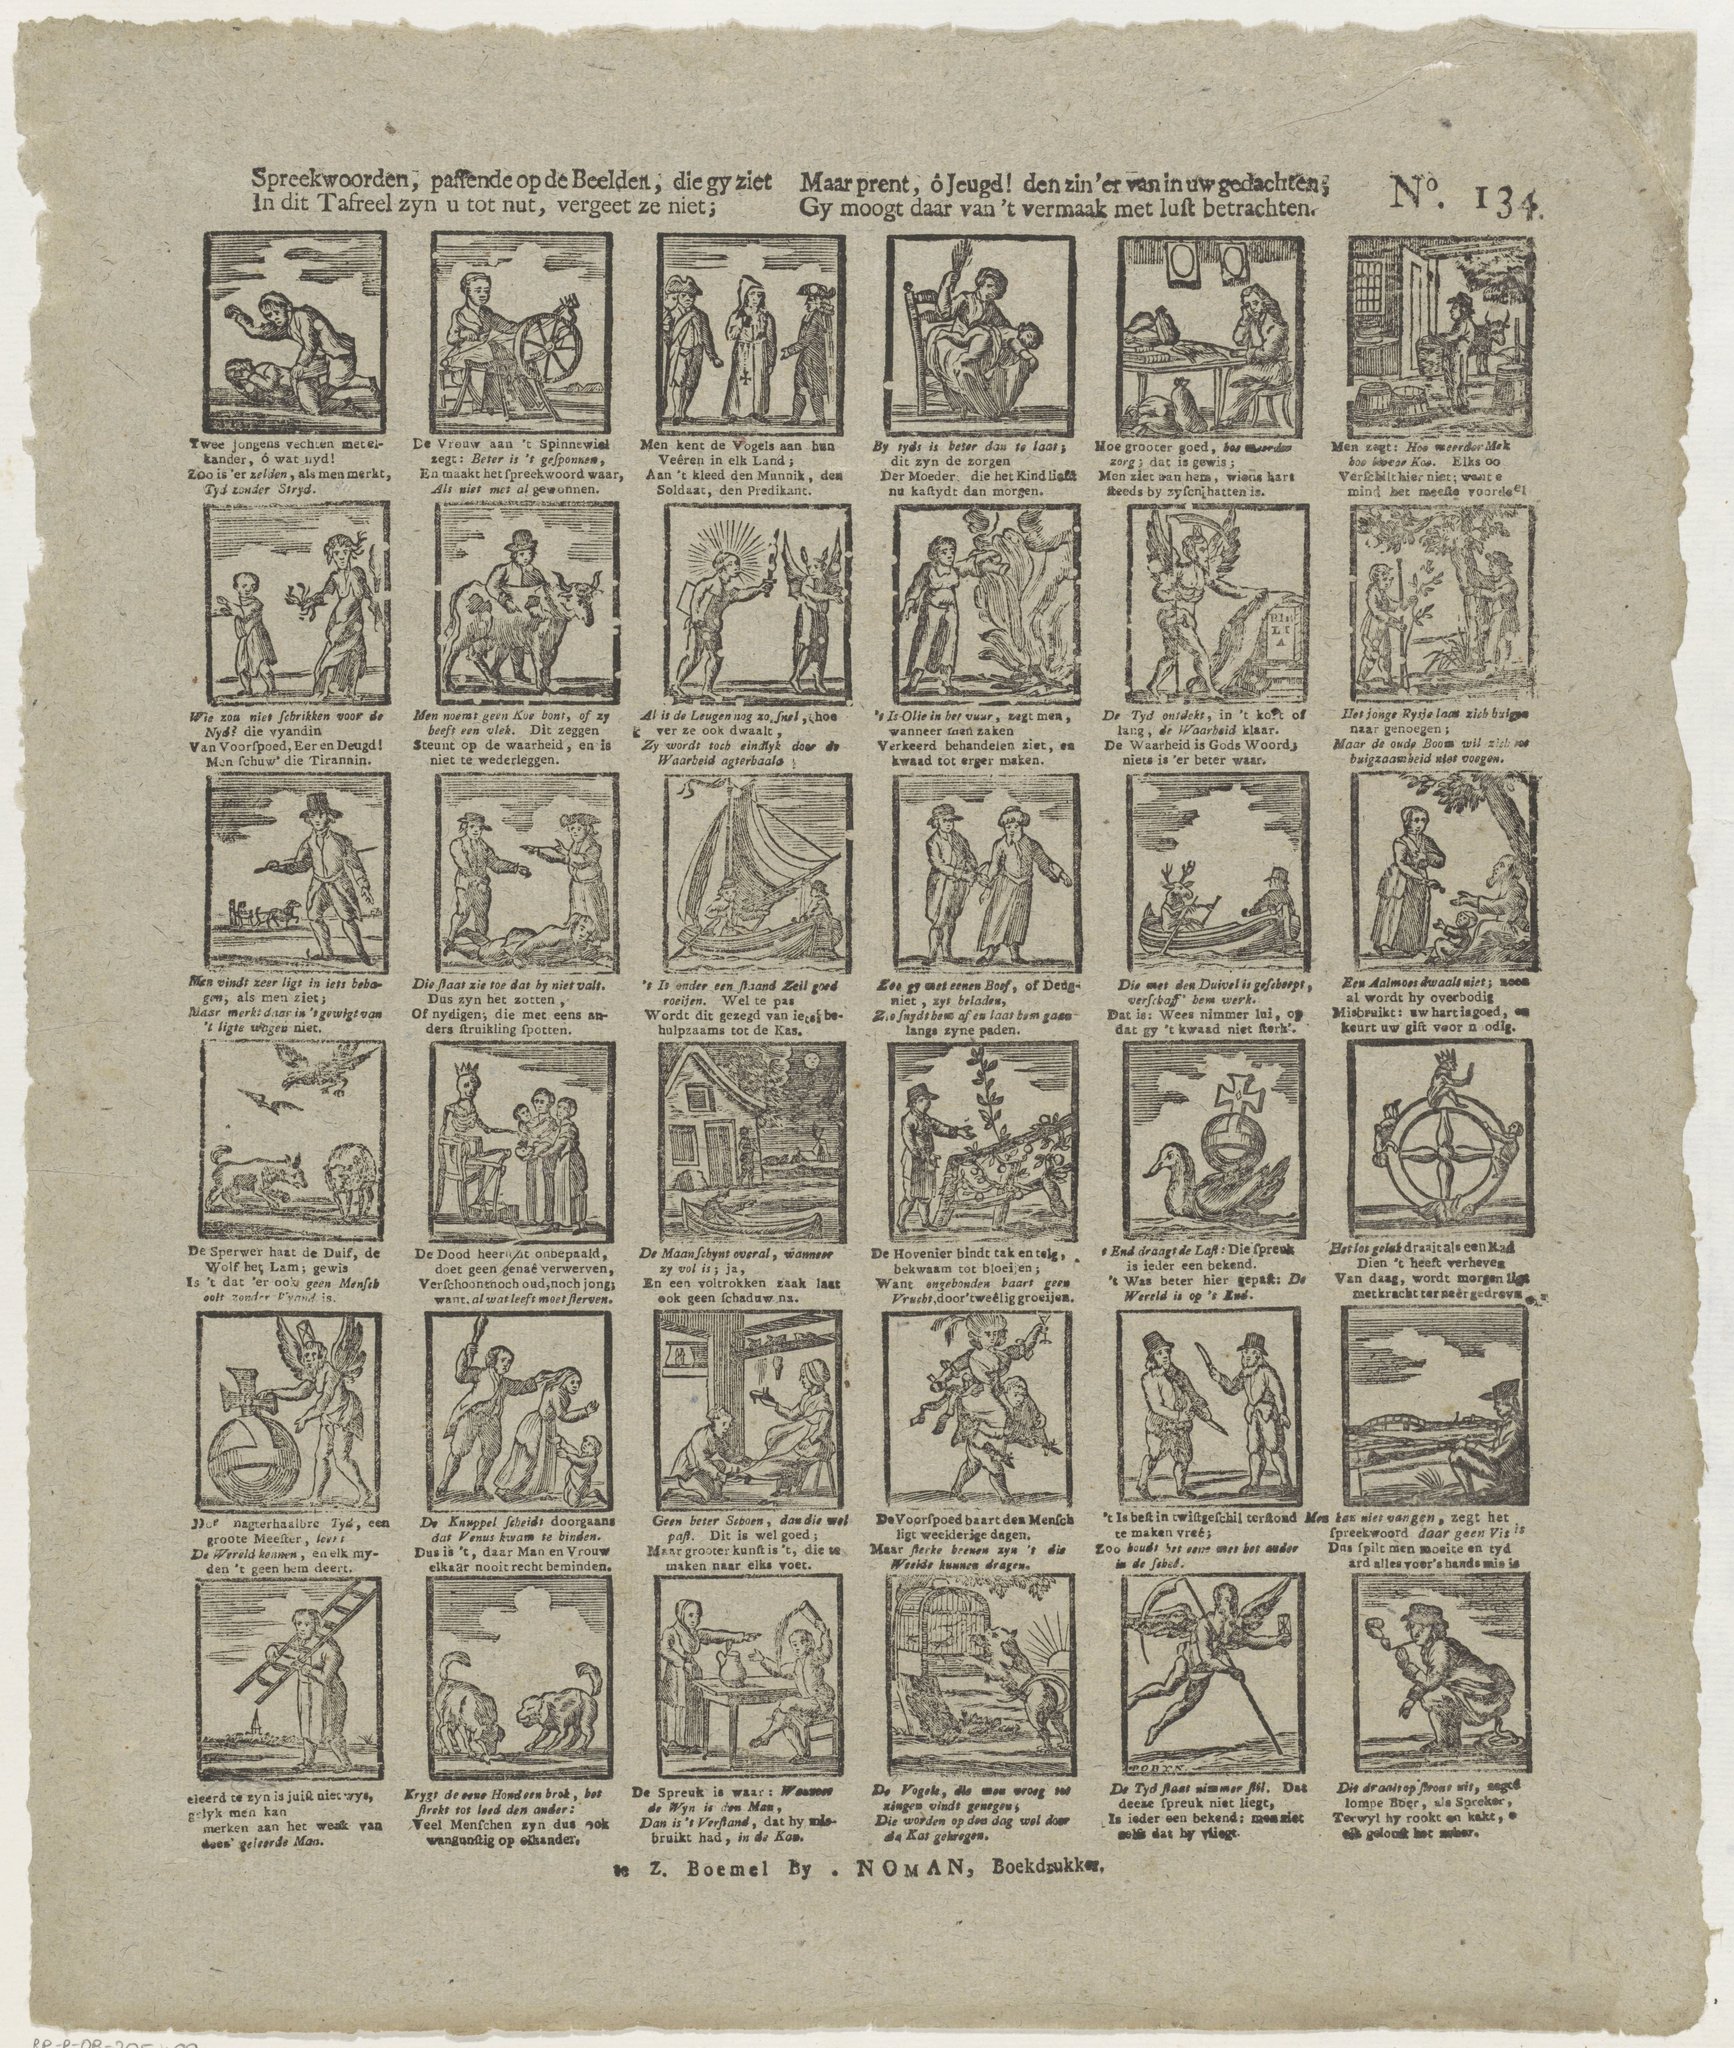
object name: popular print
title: Spreekwoorden, passende op de beelden, die gy ziet / In dit tafreel zyn u tot nut, vergeet ze niet; / Maar prent, ô jeugd! den zin 'er van in uw gedachten, / Gy moogt daar van 't vermaak met lust betrachten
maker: johan noman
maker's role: printer, publisher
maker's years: -1833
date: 1806-1830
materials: paper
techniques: letterpress printing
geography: zaltbommel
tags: proverbs, sayings, etc.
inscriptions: collector's mark: Lugt 2760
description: Blad met 36 verbeeldingen van spreekwoorden. Onder elke afbeelding een vierregelig vers. Genummerd rechtsboven: No. 134.